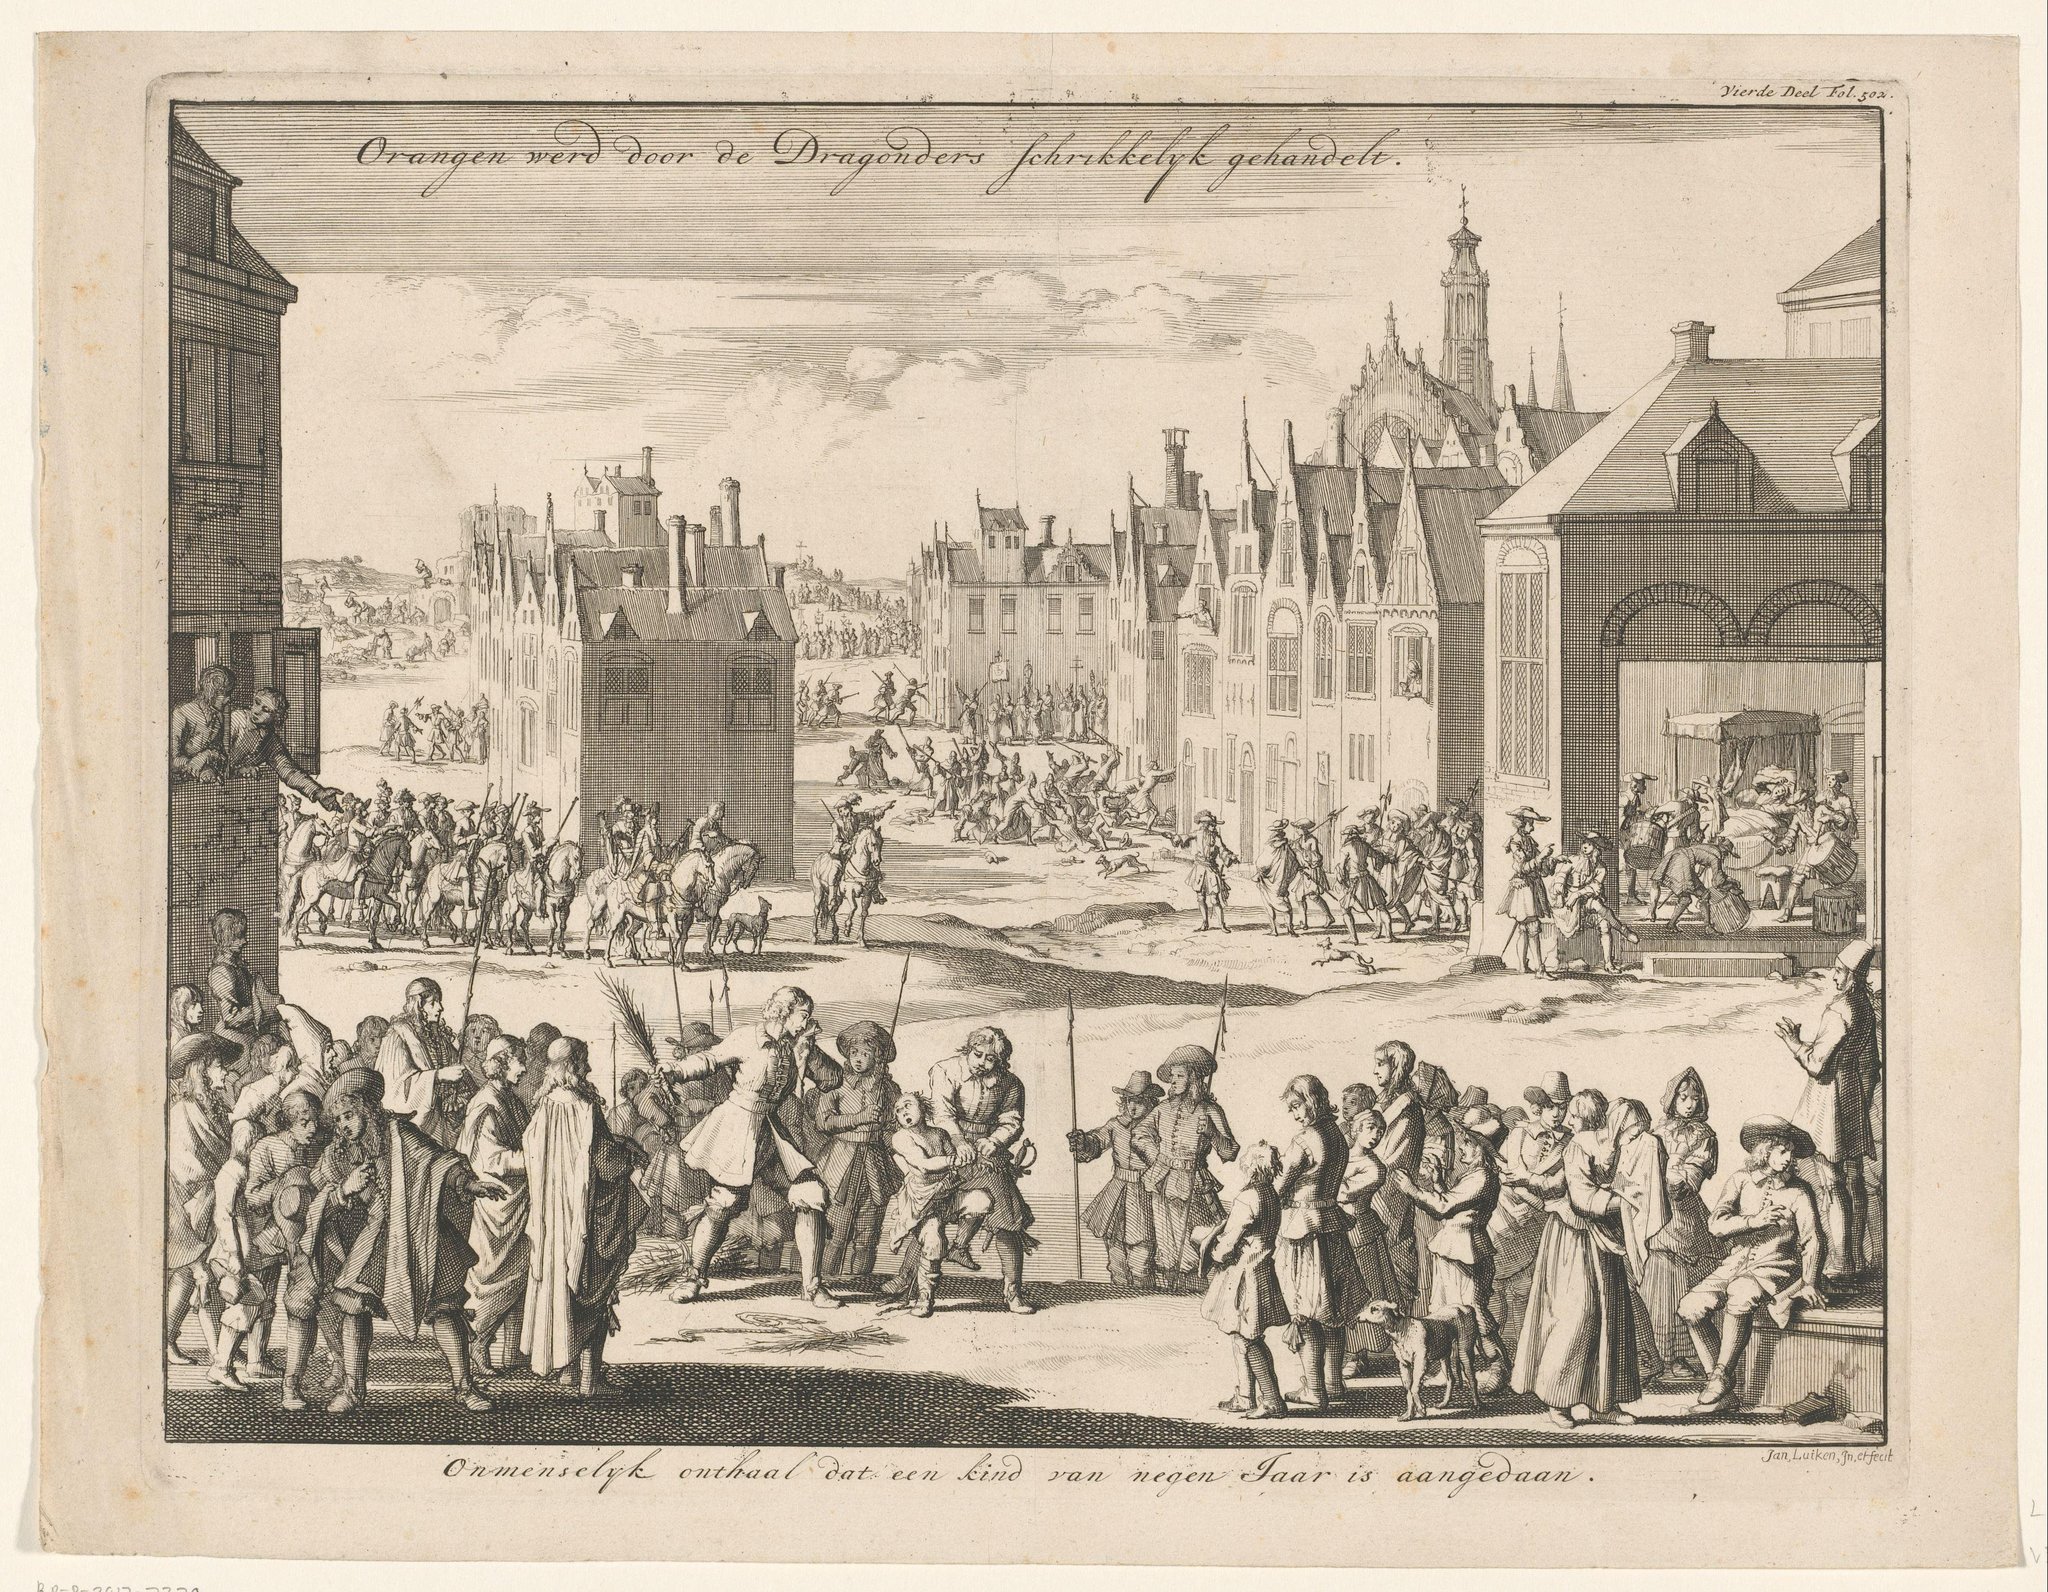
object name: print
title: Orangen werd door de Dragonders schrikkelyk gehandelt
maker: jan luyken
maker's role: draughtsman, print maker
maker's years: 1649-1712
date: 1696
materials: paper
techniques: etching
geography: amsterdam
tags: soldiers taking revenge, persecuted believers (hiding), e.g. huguenots, pilgrim fathers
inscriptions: collector's mark: Lugt 240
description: Orange opgeschrikt door gruwelijke daden van de cavalerie, na de herroeping van het Edict van Nantes, 1685. Op de voorgrond wordt een kind op straat gegeseld. Prent rechtsboven gemerkt: Vierde Deel Fol. 281.